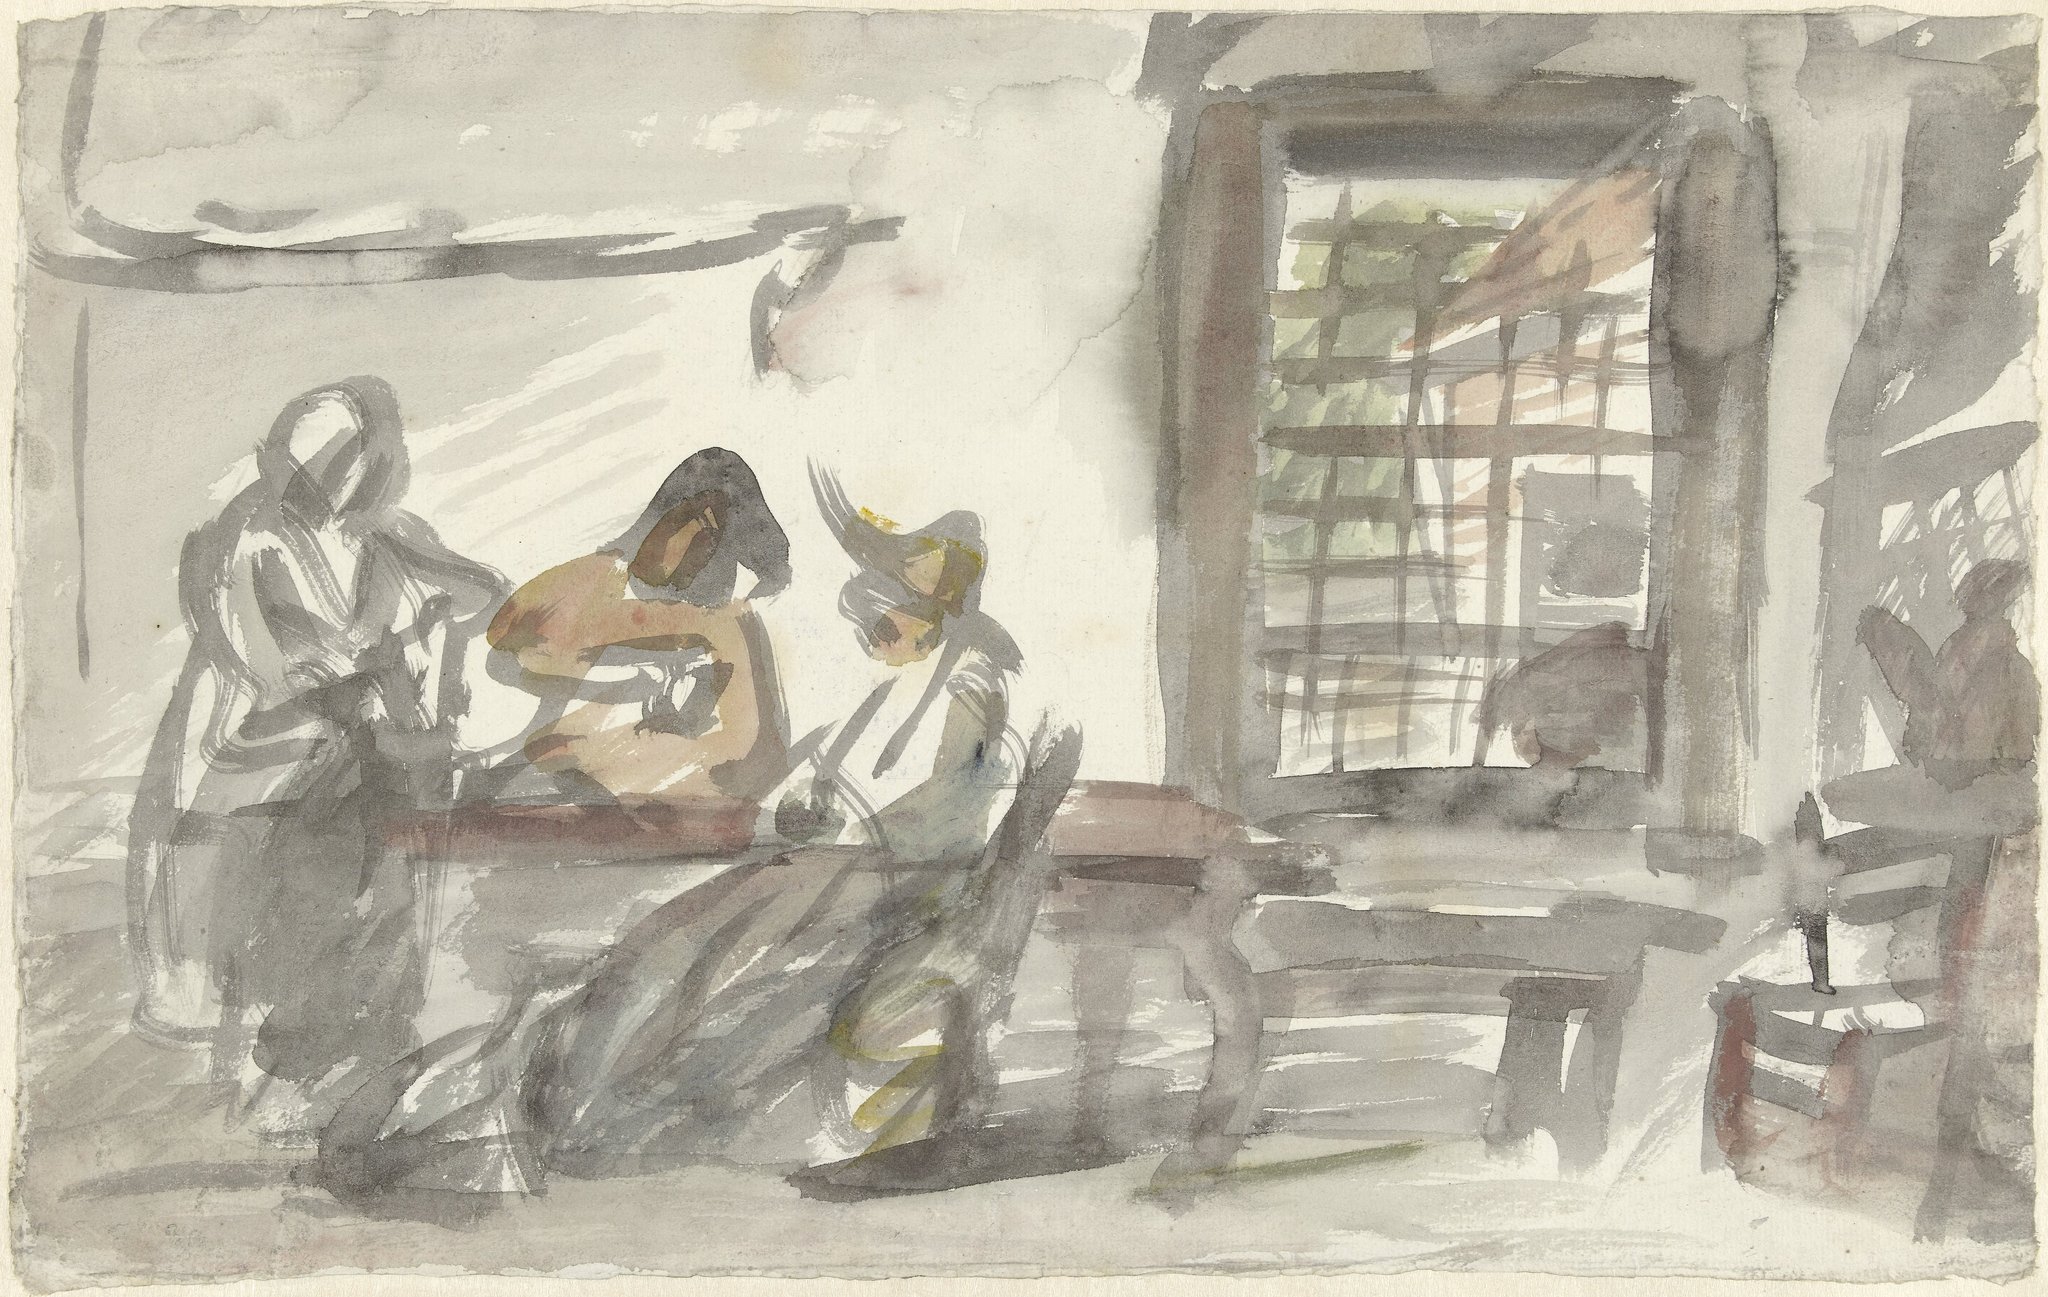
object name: drawing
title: Interieur van een boerenherberg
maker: simon andreas krausz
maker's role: draughtsman, print maker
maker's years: 1760-1825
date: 1770-1825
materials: paper, watercolor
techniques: brush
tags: inn, coffee-house, public house, etc.